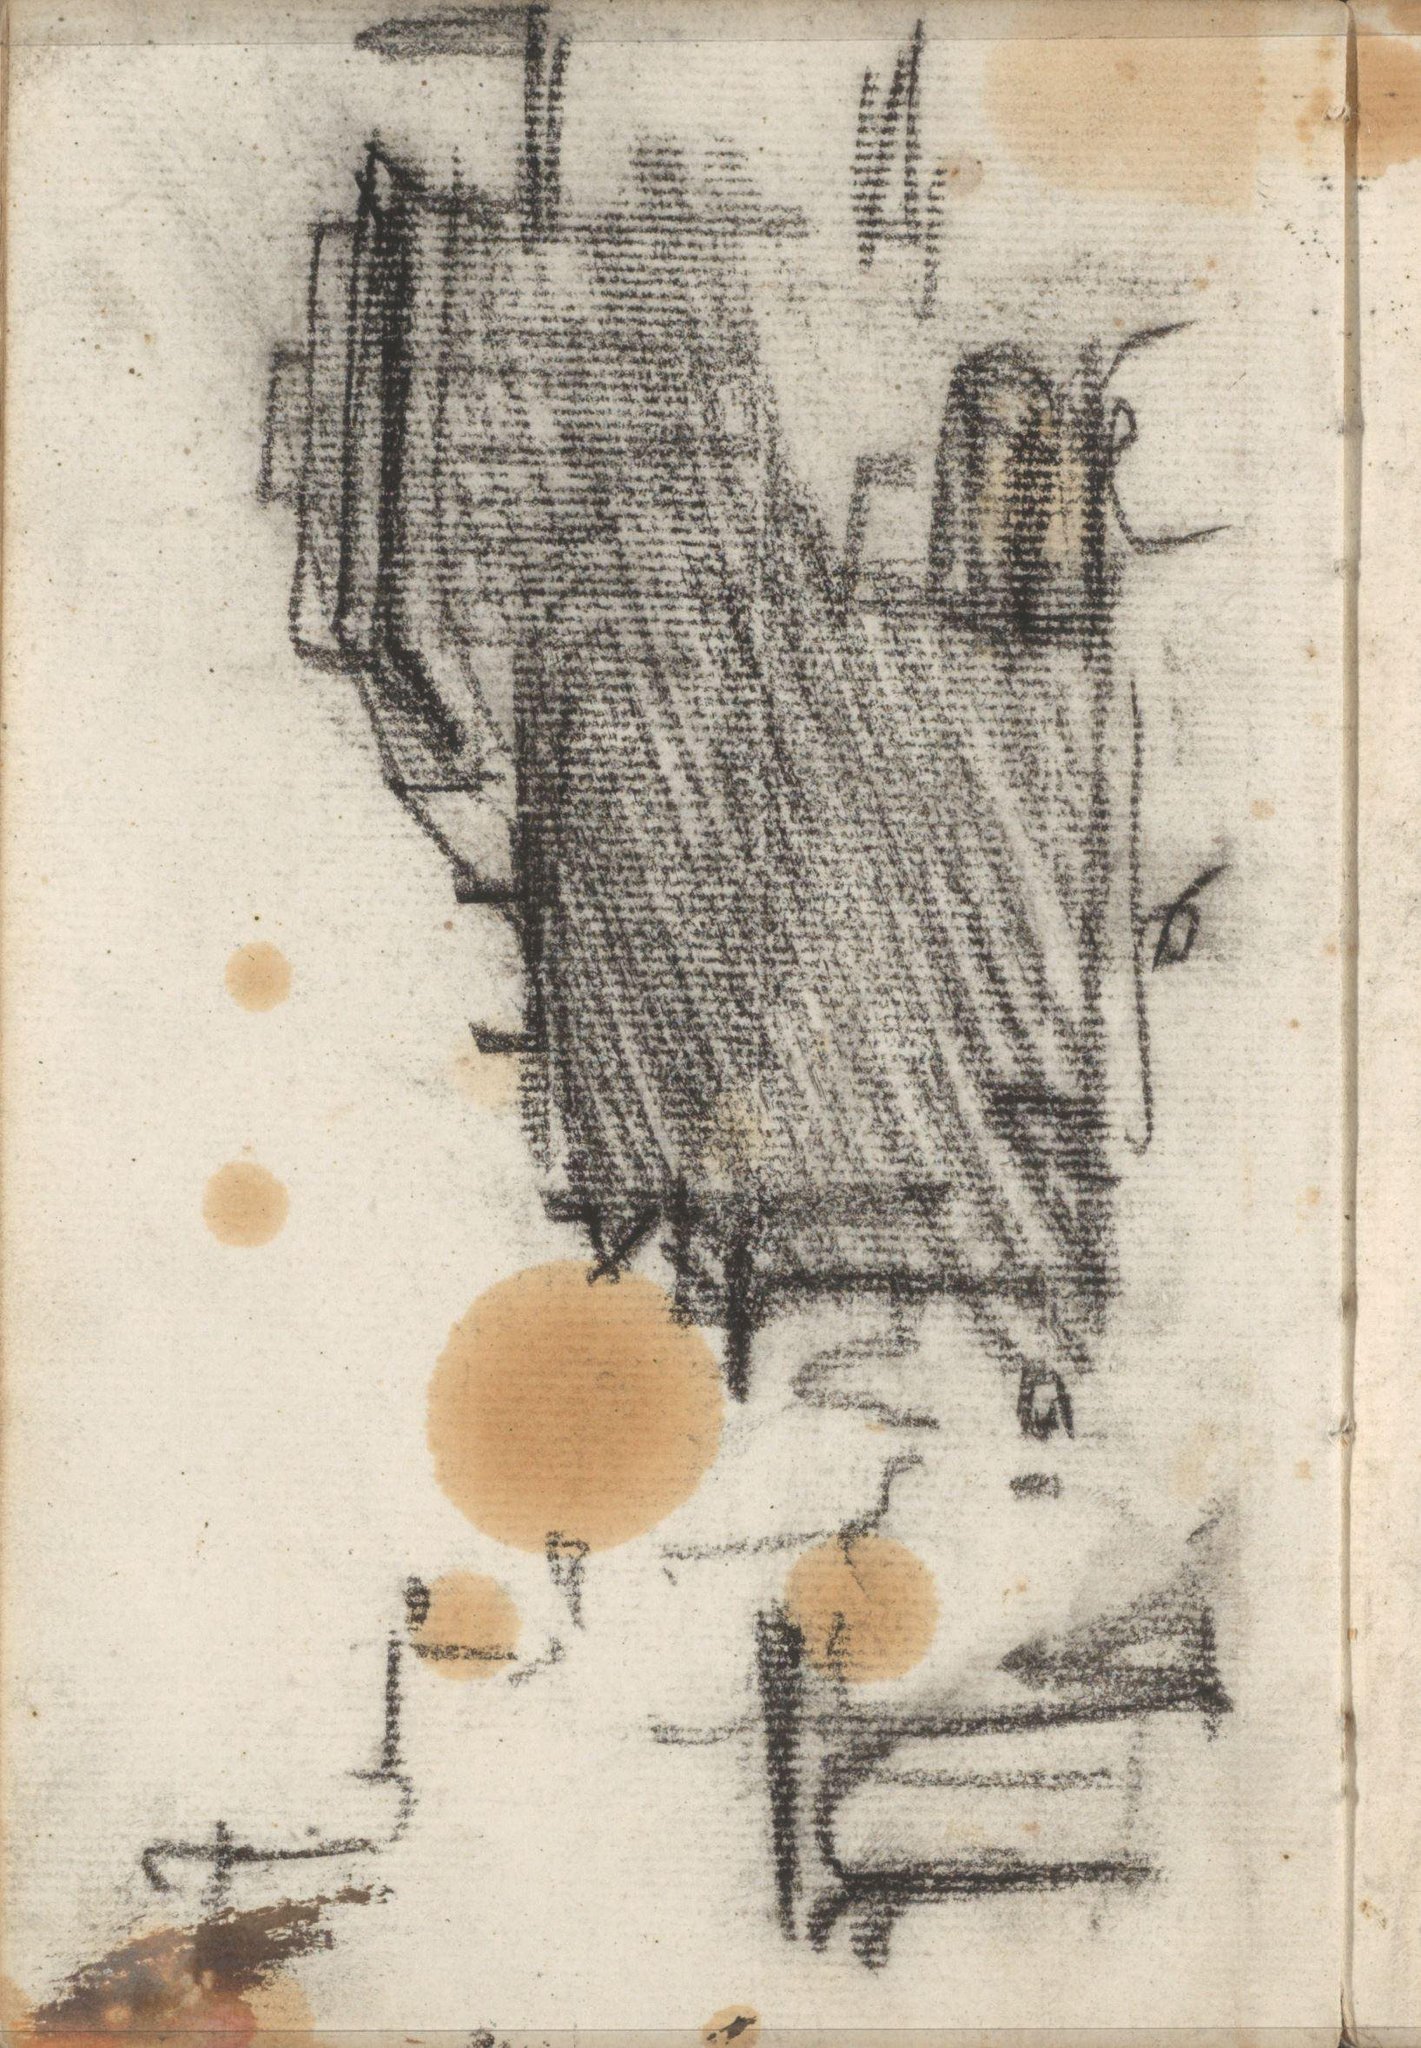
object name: sketchbook leaf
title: Gezicht op de Beurs van Zocher op de Dam te Amsterdam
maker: george hendrik breitner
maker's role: draughtsman, painter, print maker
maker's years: 1857-1923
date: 1895-1898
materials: chalk, paper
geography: amsterdam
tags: square, place, circus, etc., street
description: Links de ingang van het Damrak. Pagina 11 uit een schetsboek met 20 bladen.